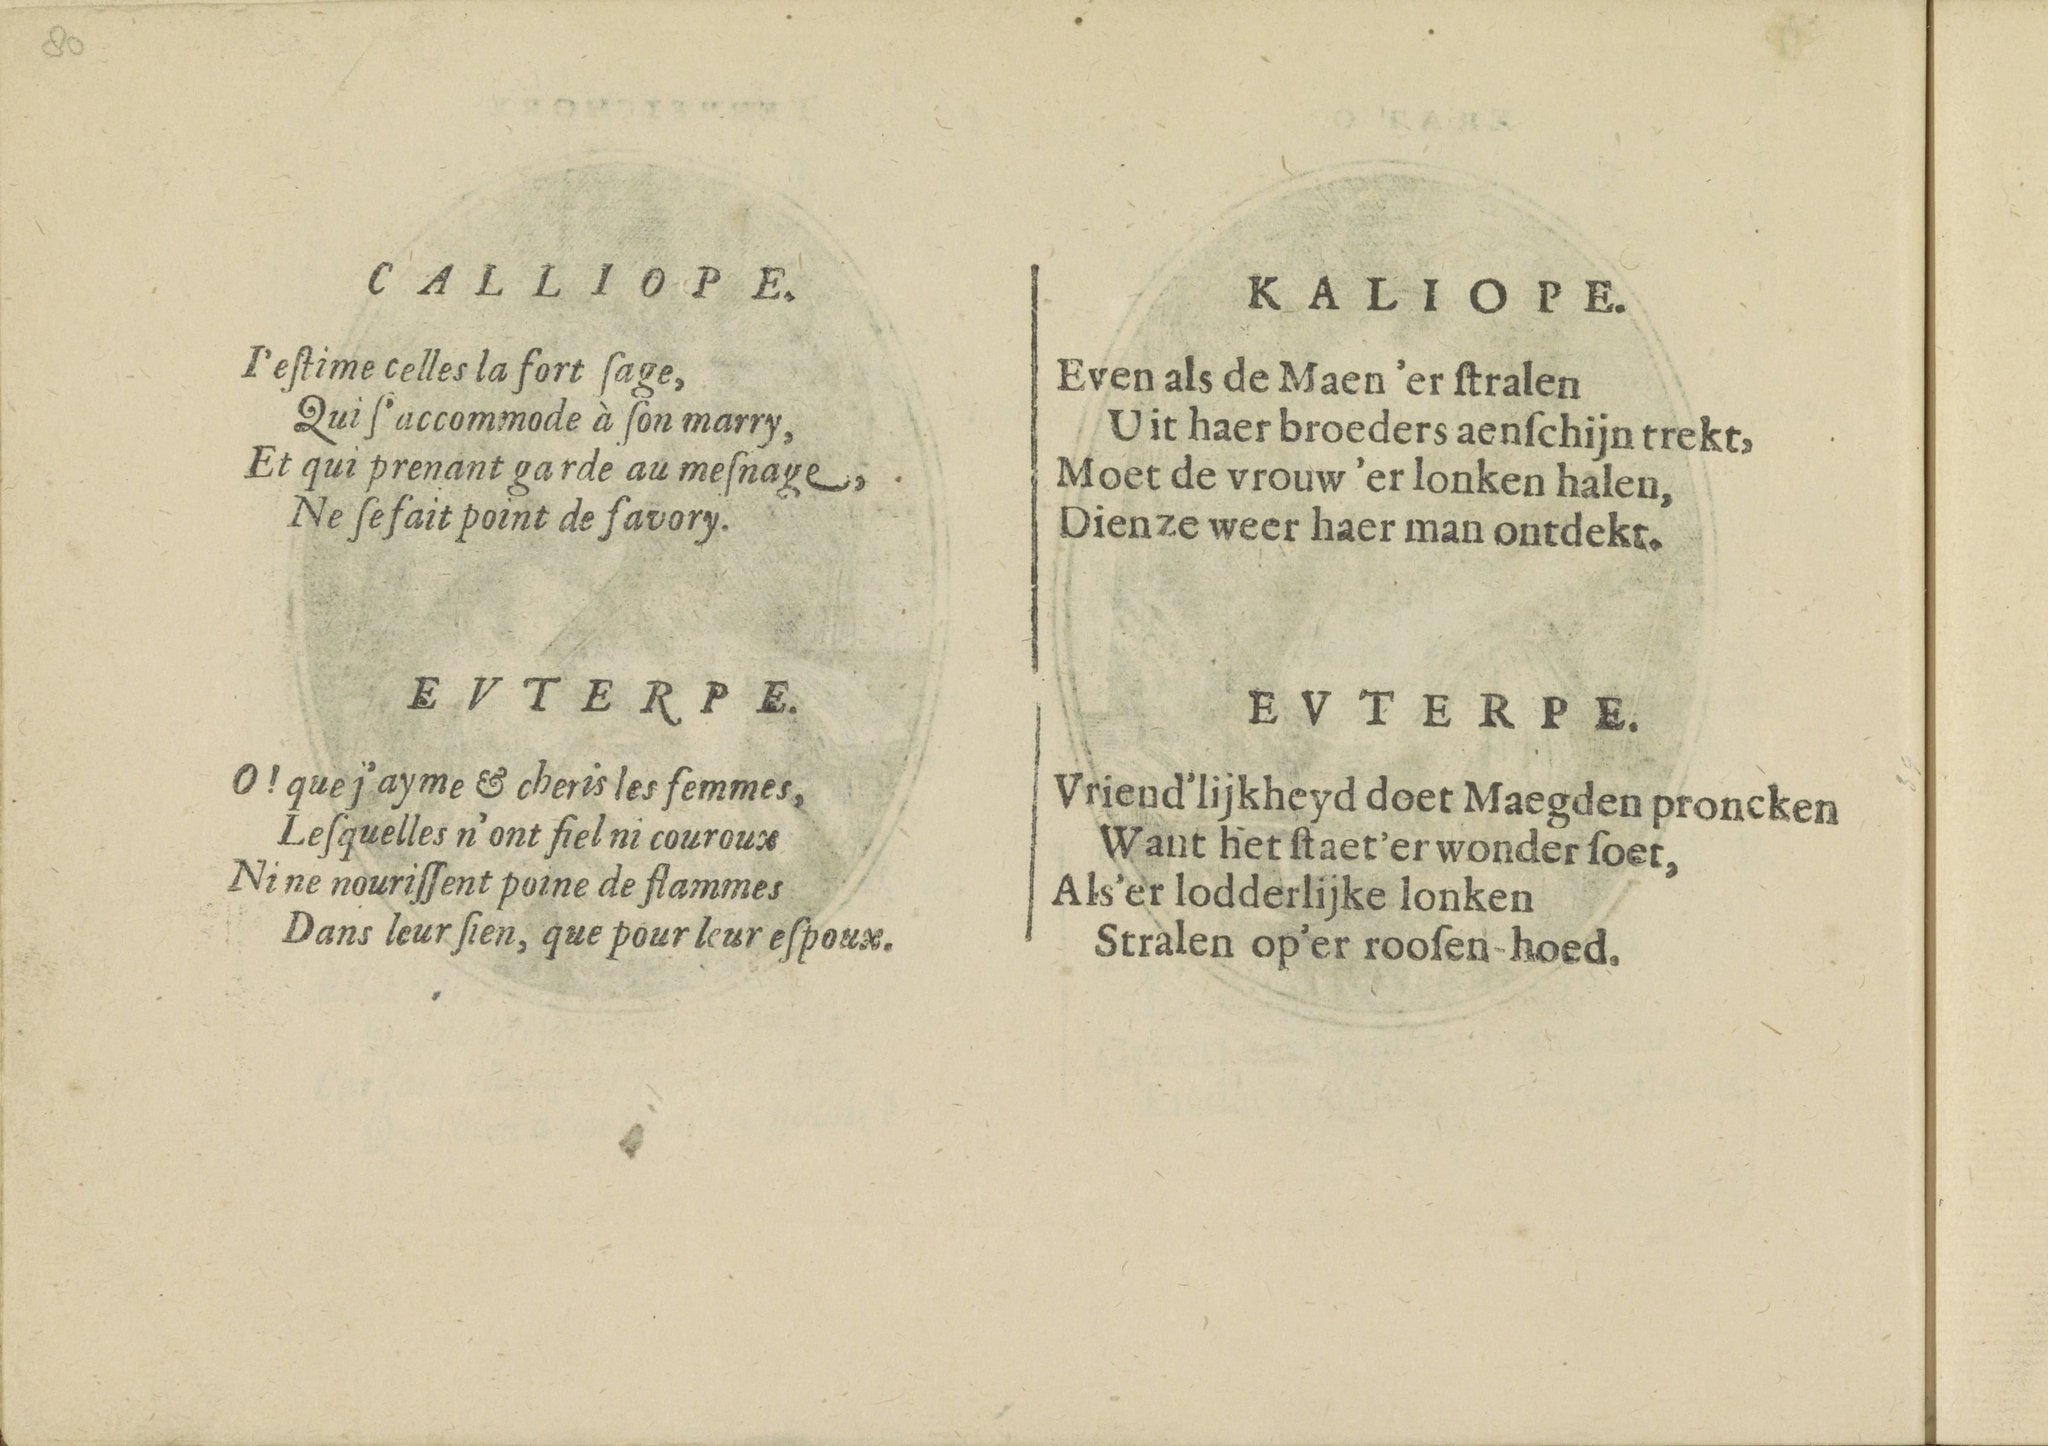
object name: text sheet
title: Kwatrijnen bij de voorstellingen van de muzen Calliope en Euterpe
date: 1640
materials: paper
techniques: letterpress printing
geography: amsterdam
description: Twee keer twee kwatrijnen in het Frans en Nederlands bij de voorstellingen van de muzen Calliope en Euterpe. Het blad maakt deel uit van een album.